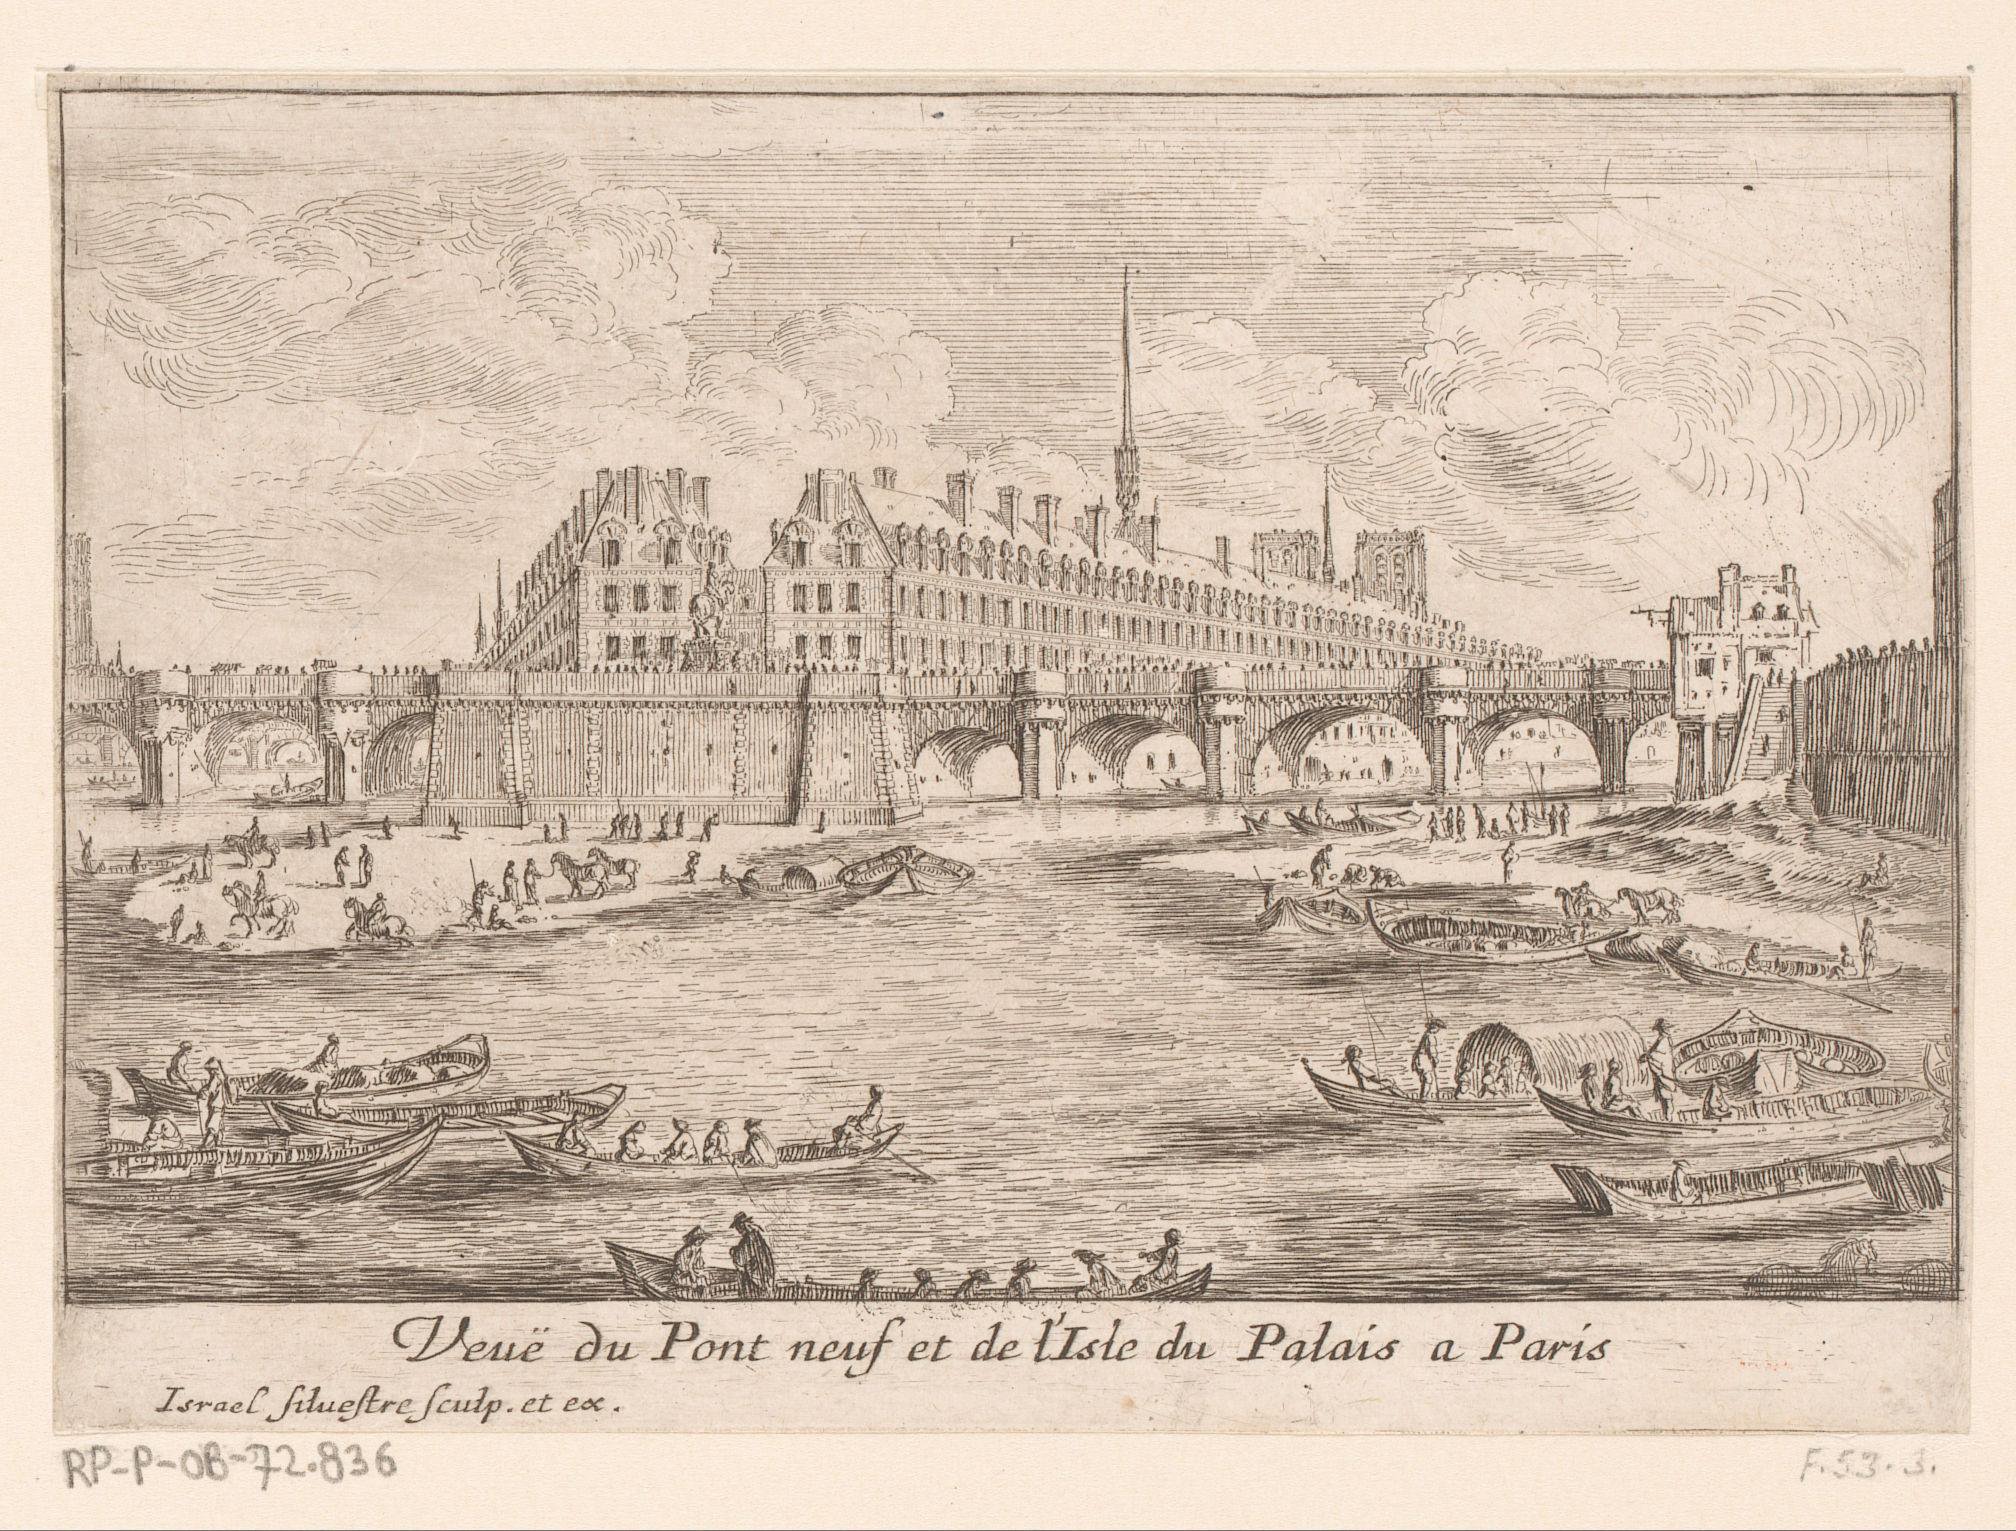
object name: print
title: Diverse gezichten, perspectieven en landschappen naar de natuur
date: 1631-1691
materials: paper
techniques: etching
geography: france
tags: river, landscape with bridge, viaduct or aqueduct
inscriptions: collector's mark: Lugt 240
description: Prent maakt deel uit van een genummerde serie van negen prenten, maar de nummers zijn afgesneden. Dit is vermoedelijk nummer 3.